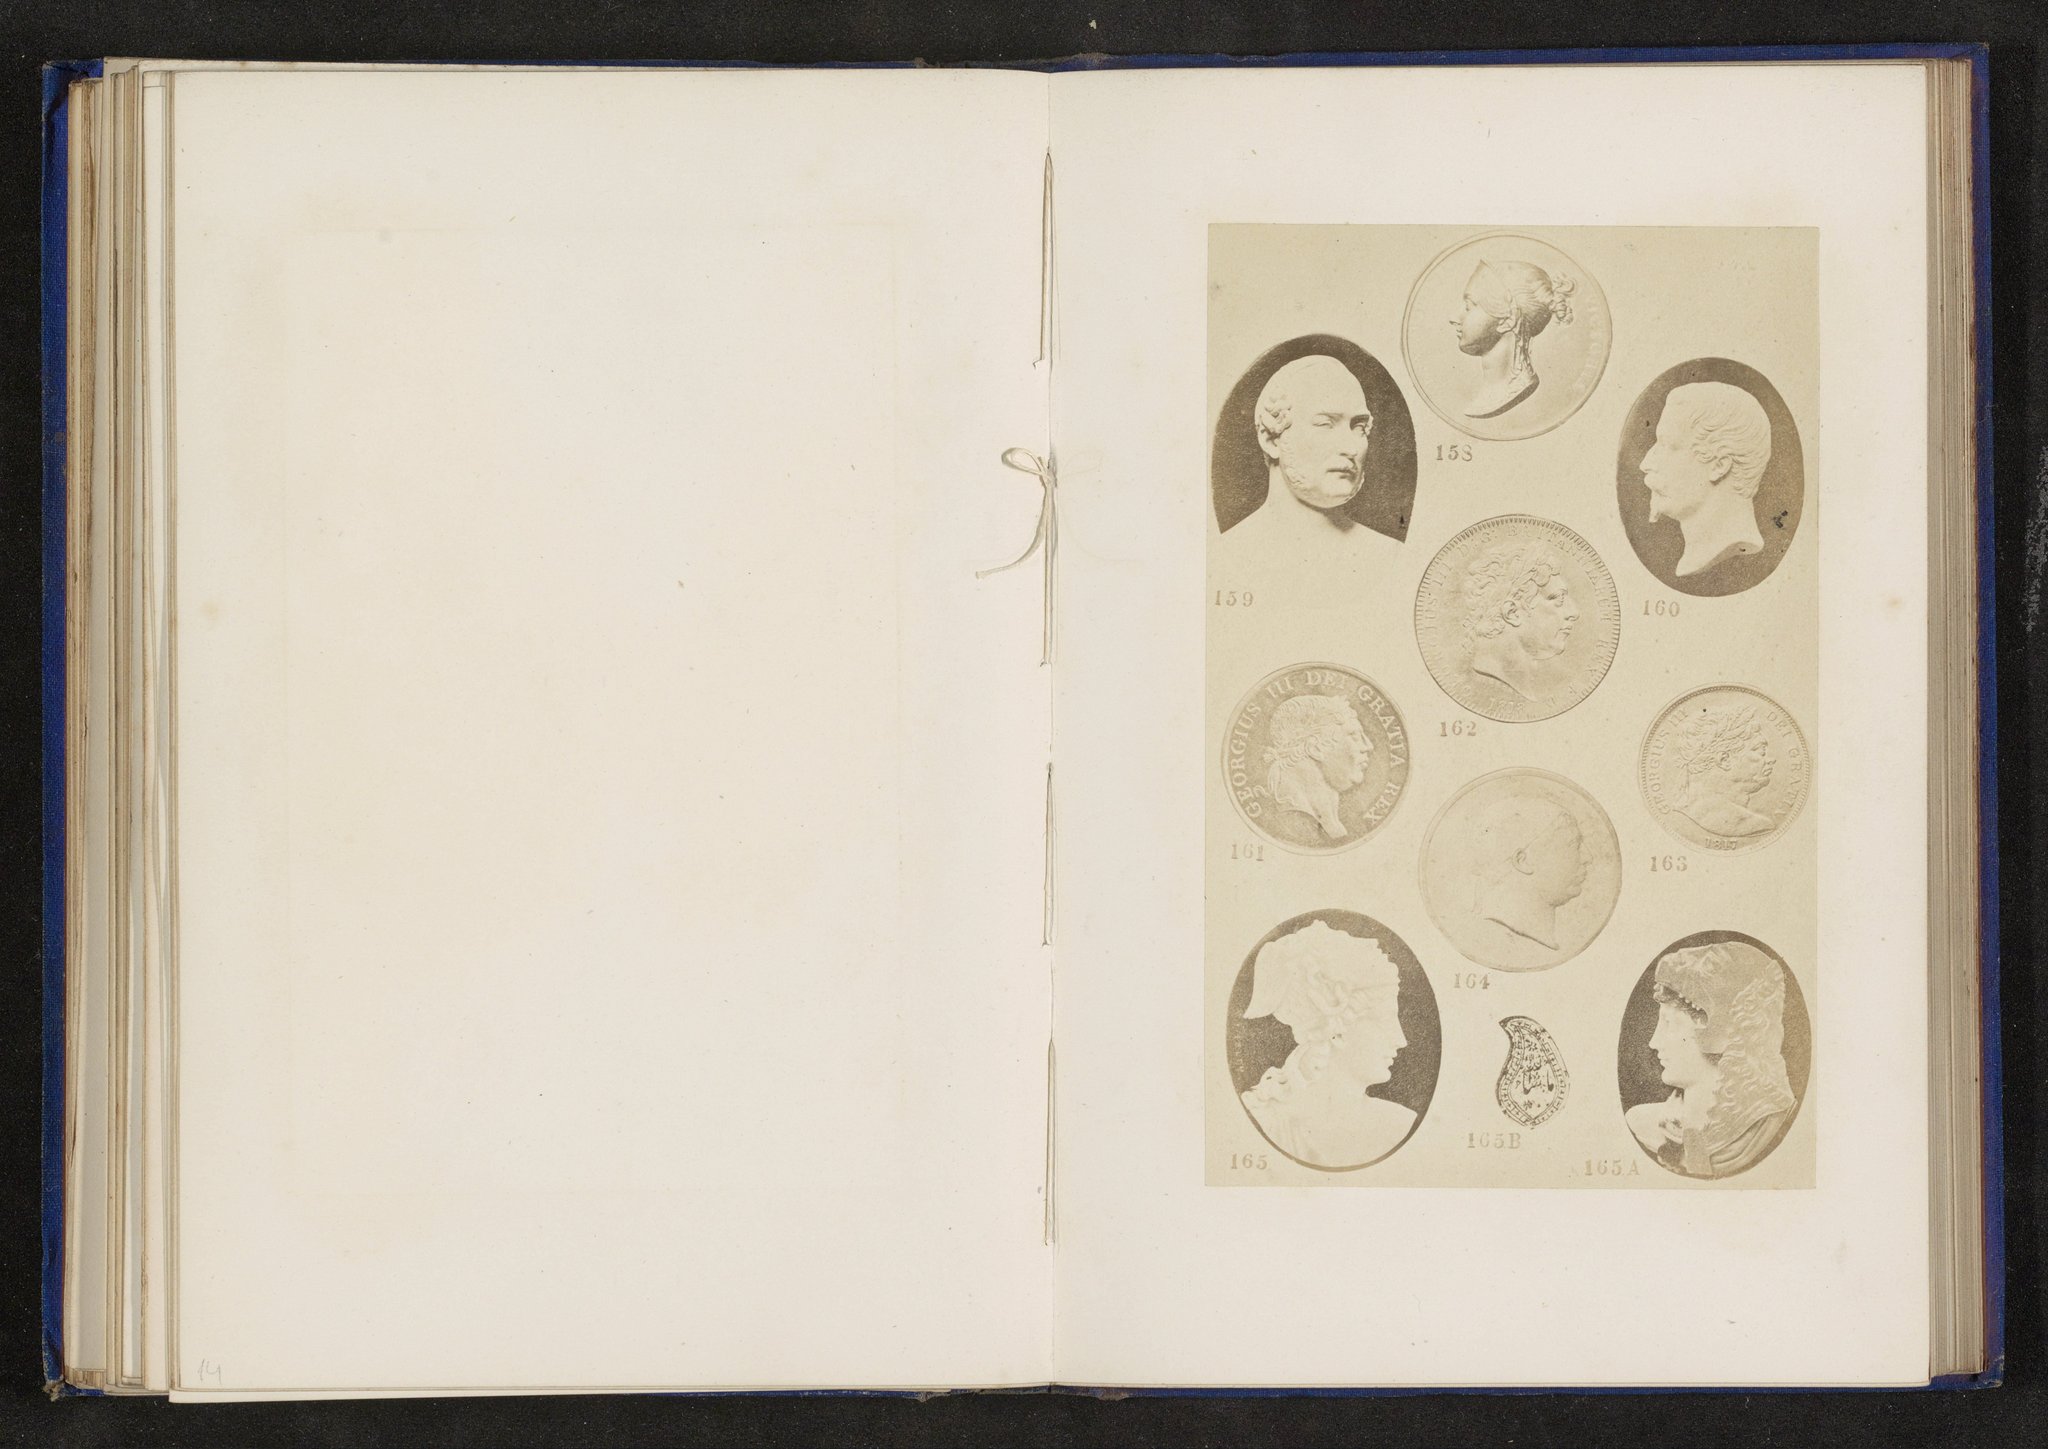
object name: photograph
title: Negen portretten in reliëf en een Turkse ring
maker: f. cole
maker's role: fotograaf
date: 1857-1867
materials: photographic support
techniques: albumen print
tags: ring, sculpture, sculpture (+ relief ~ sculpture)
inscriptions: number: ‘158 -165A’